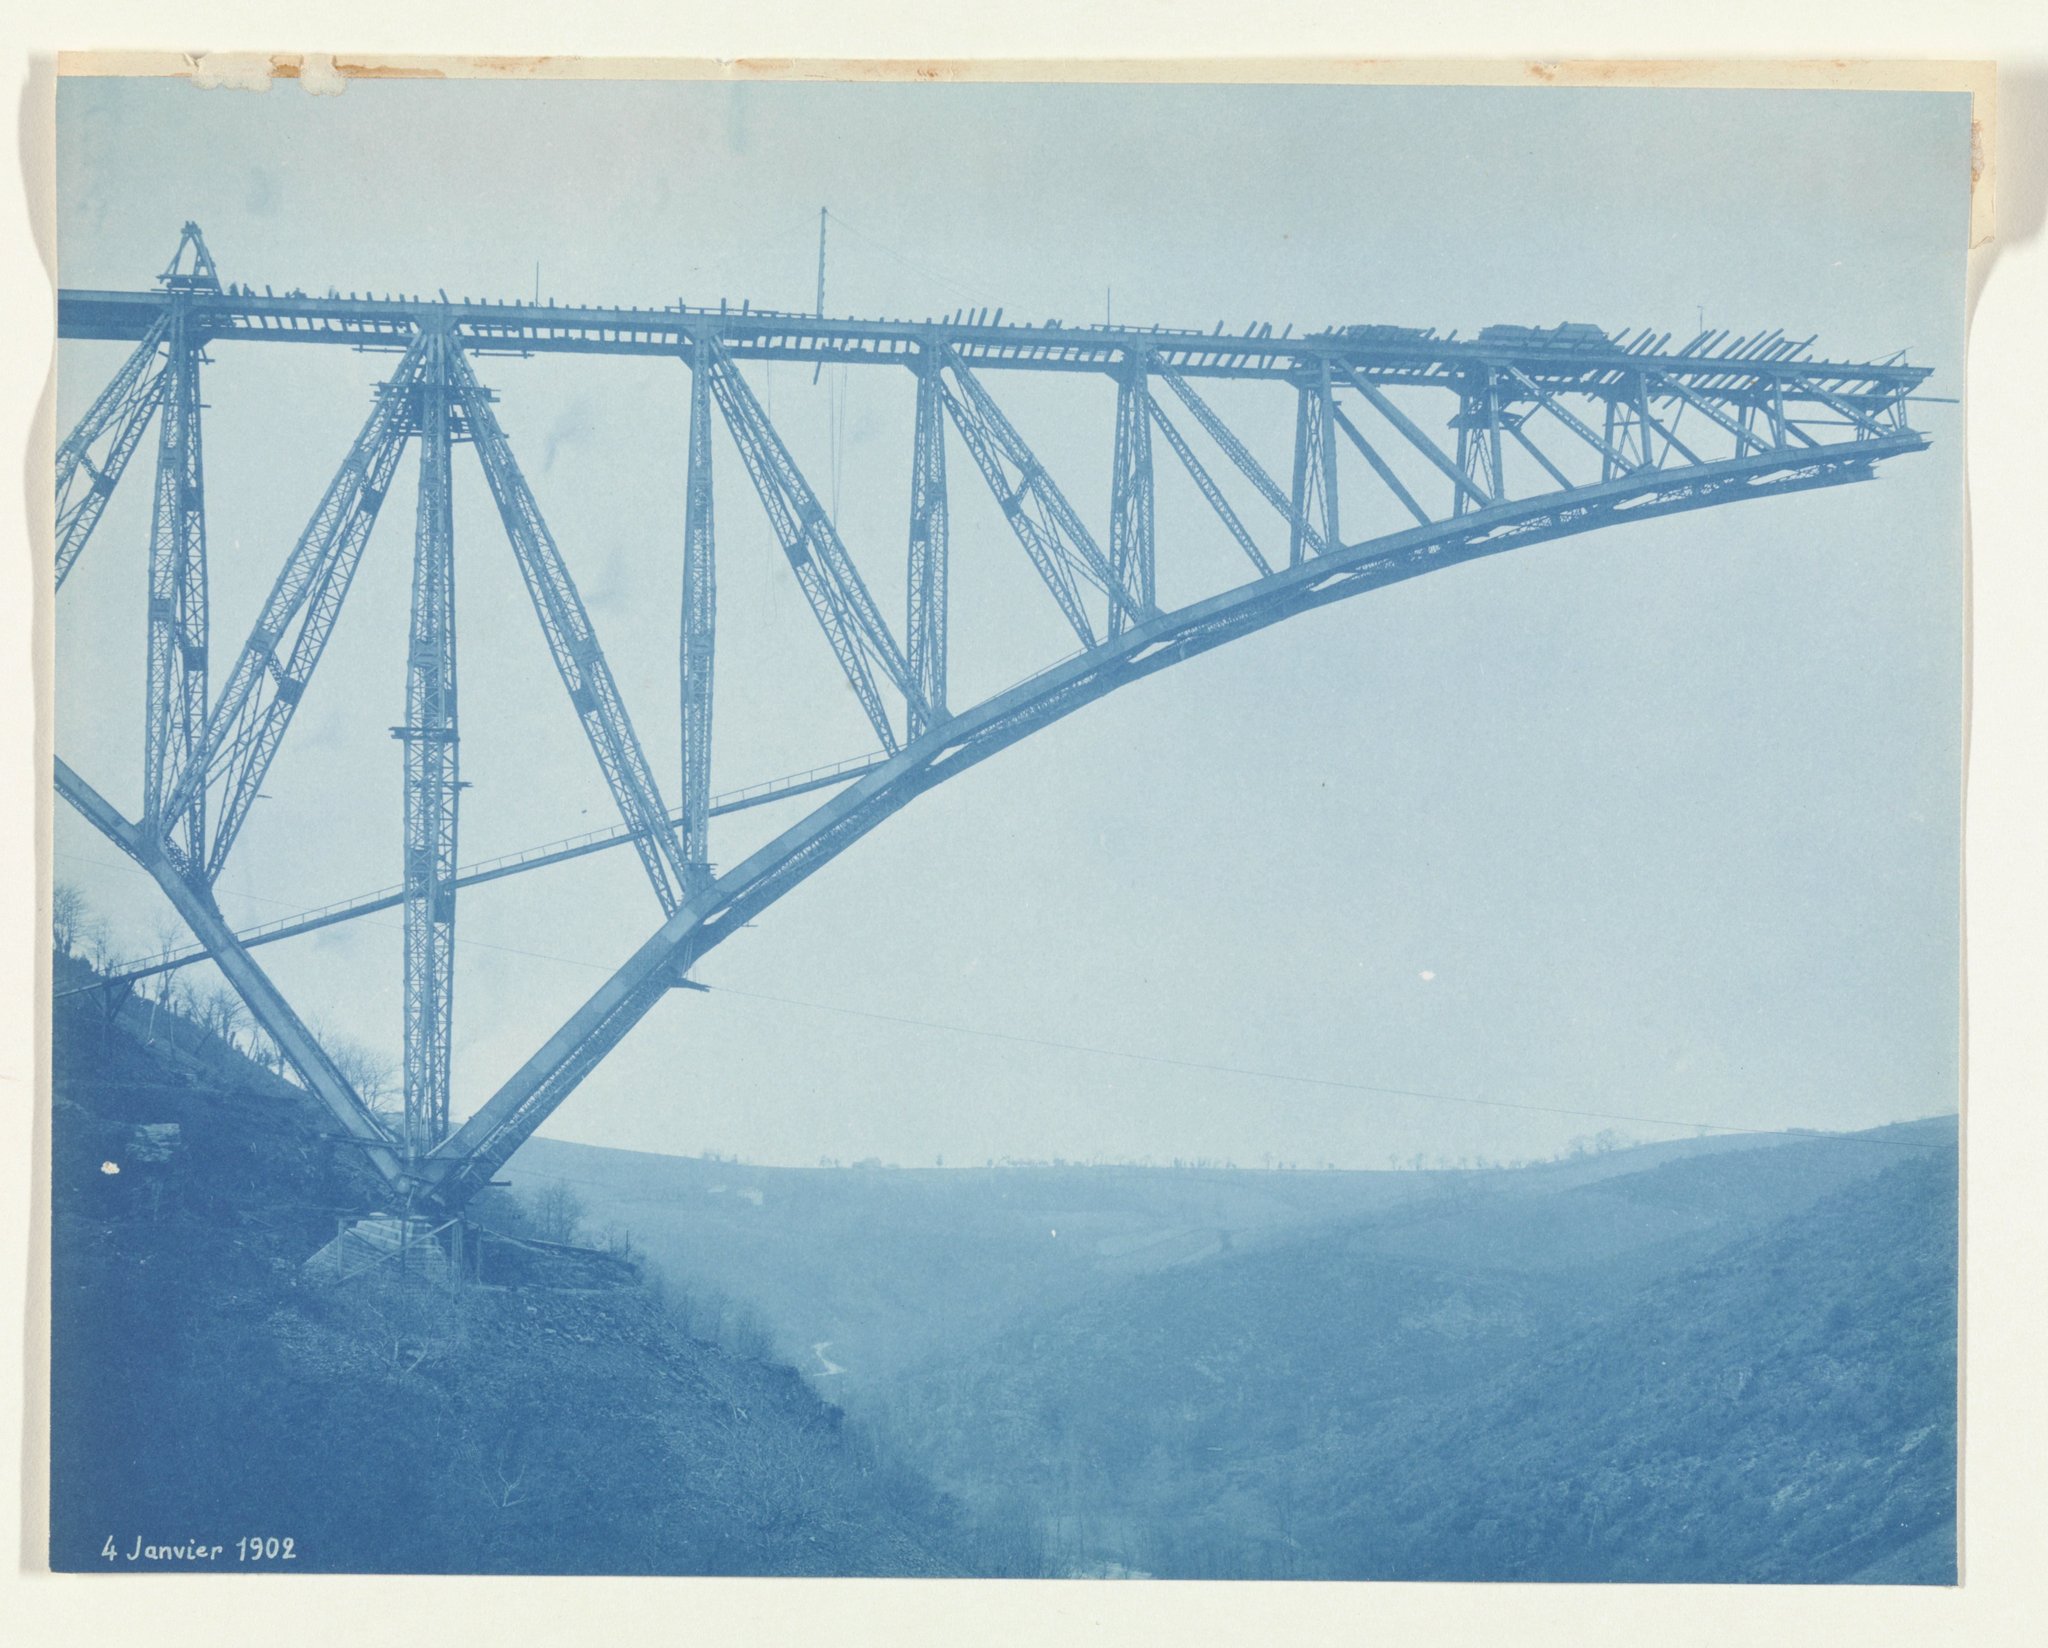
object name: photograph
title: Aanleg van het Viaur Viaduct in Frankrijk door de Societé de Construction des Battignolles, 4 januari 1902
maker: Anonymous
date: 1902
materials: photographic support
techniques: cyanotype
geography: france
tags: viaduct, making the overground structures (~ building activities)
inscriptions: date